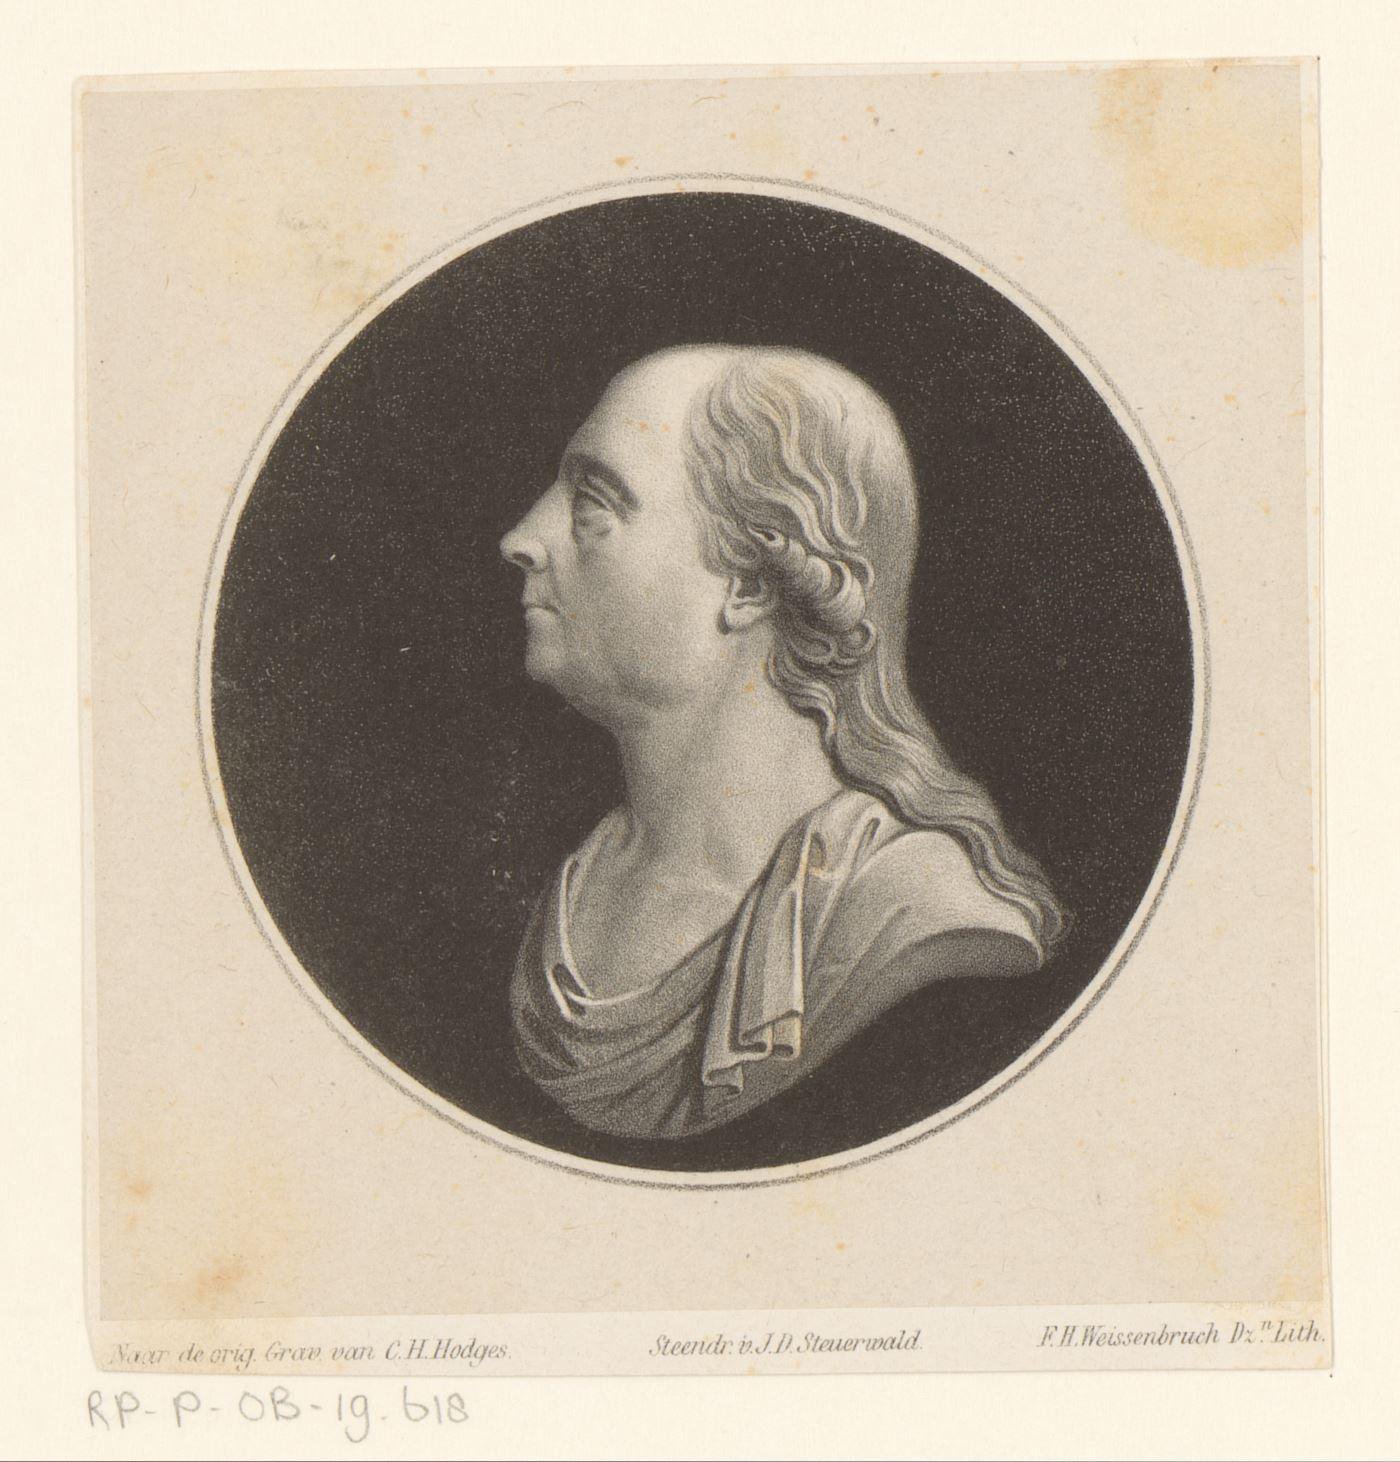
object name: book illustration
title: Profielportret van Jan Hendrik van Kinsbergen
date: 1858-1862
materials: paper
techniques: lithograph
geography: the hague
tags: jonkheer jan hendrik van kinsbergen, historical persons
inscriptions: collector's mark: Lugt 2228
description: Prent uit: Jonge, J.C. de. Geschiedenis van het Nederlandsche zeewezen. Haarlem: Jonge, J.K.J. de, 1858-62.